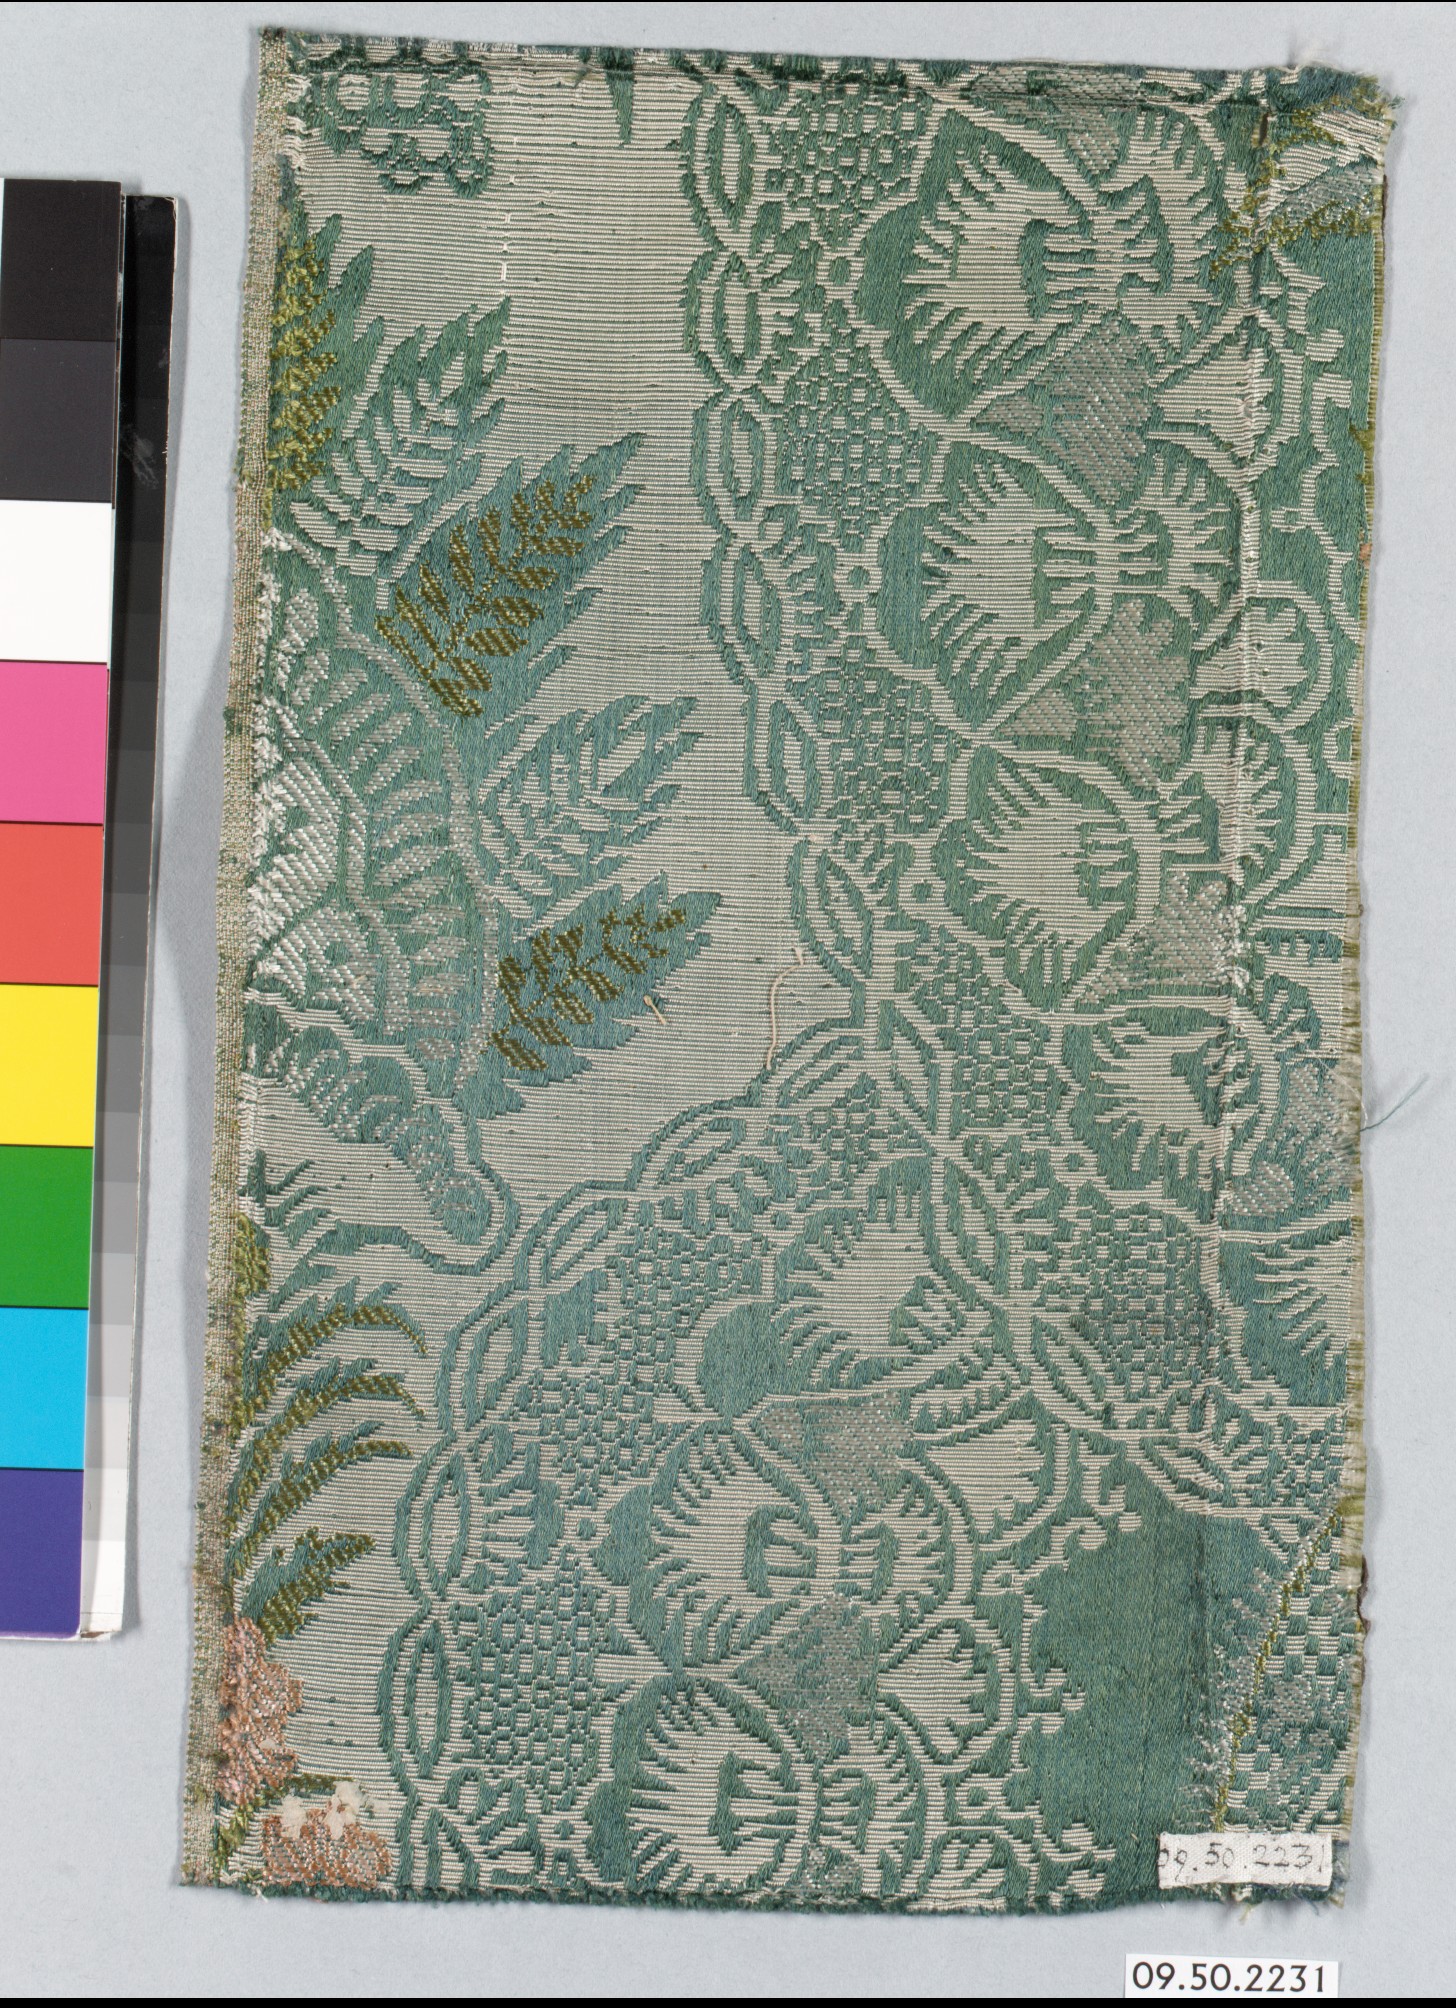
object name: piece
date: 1601-1700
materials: silk